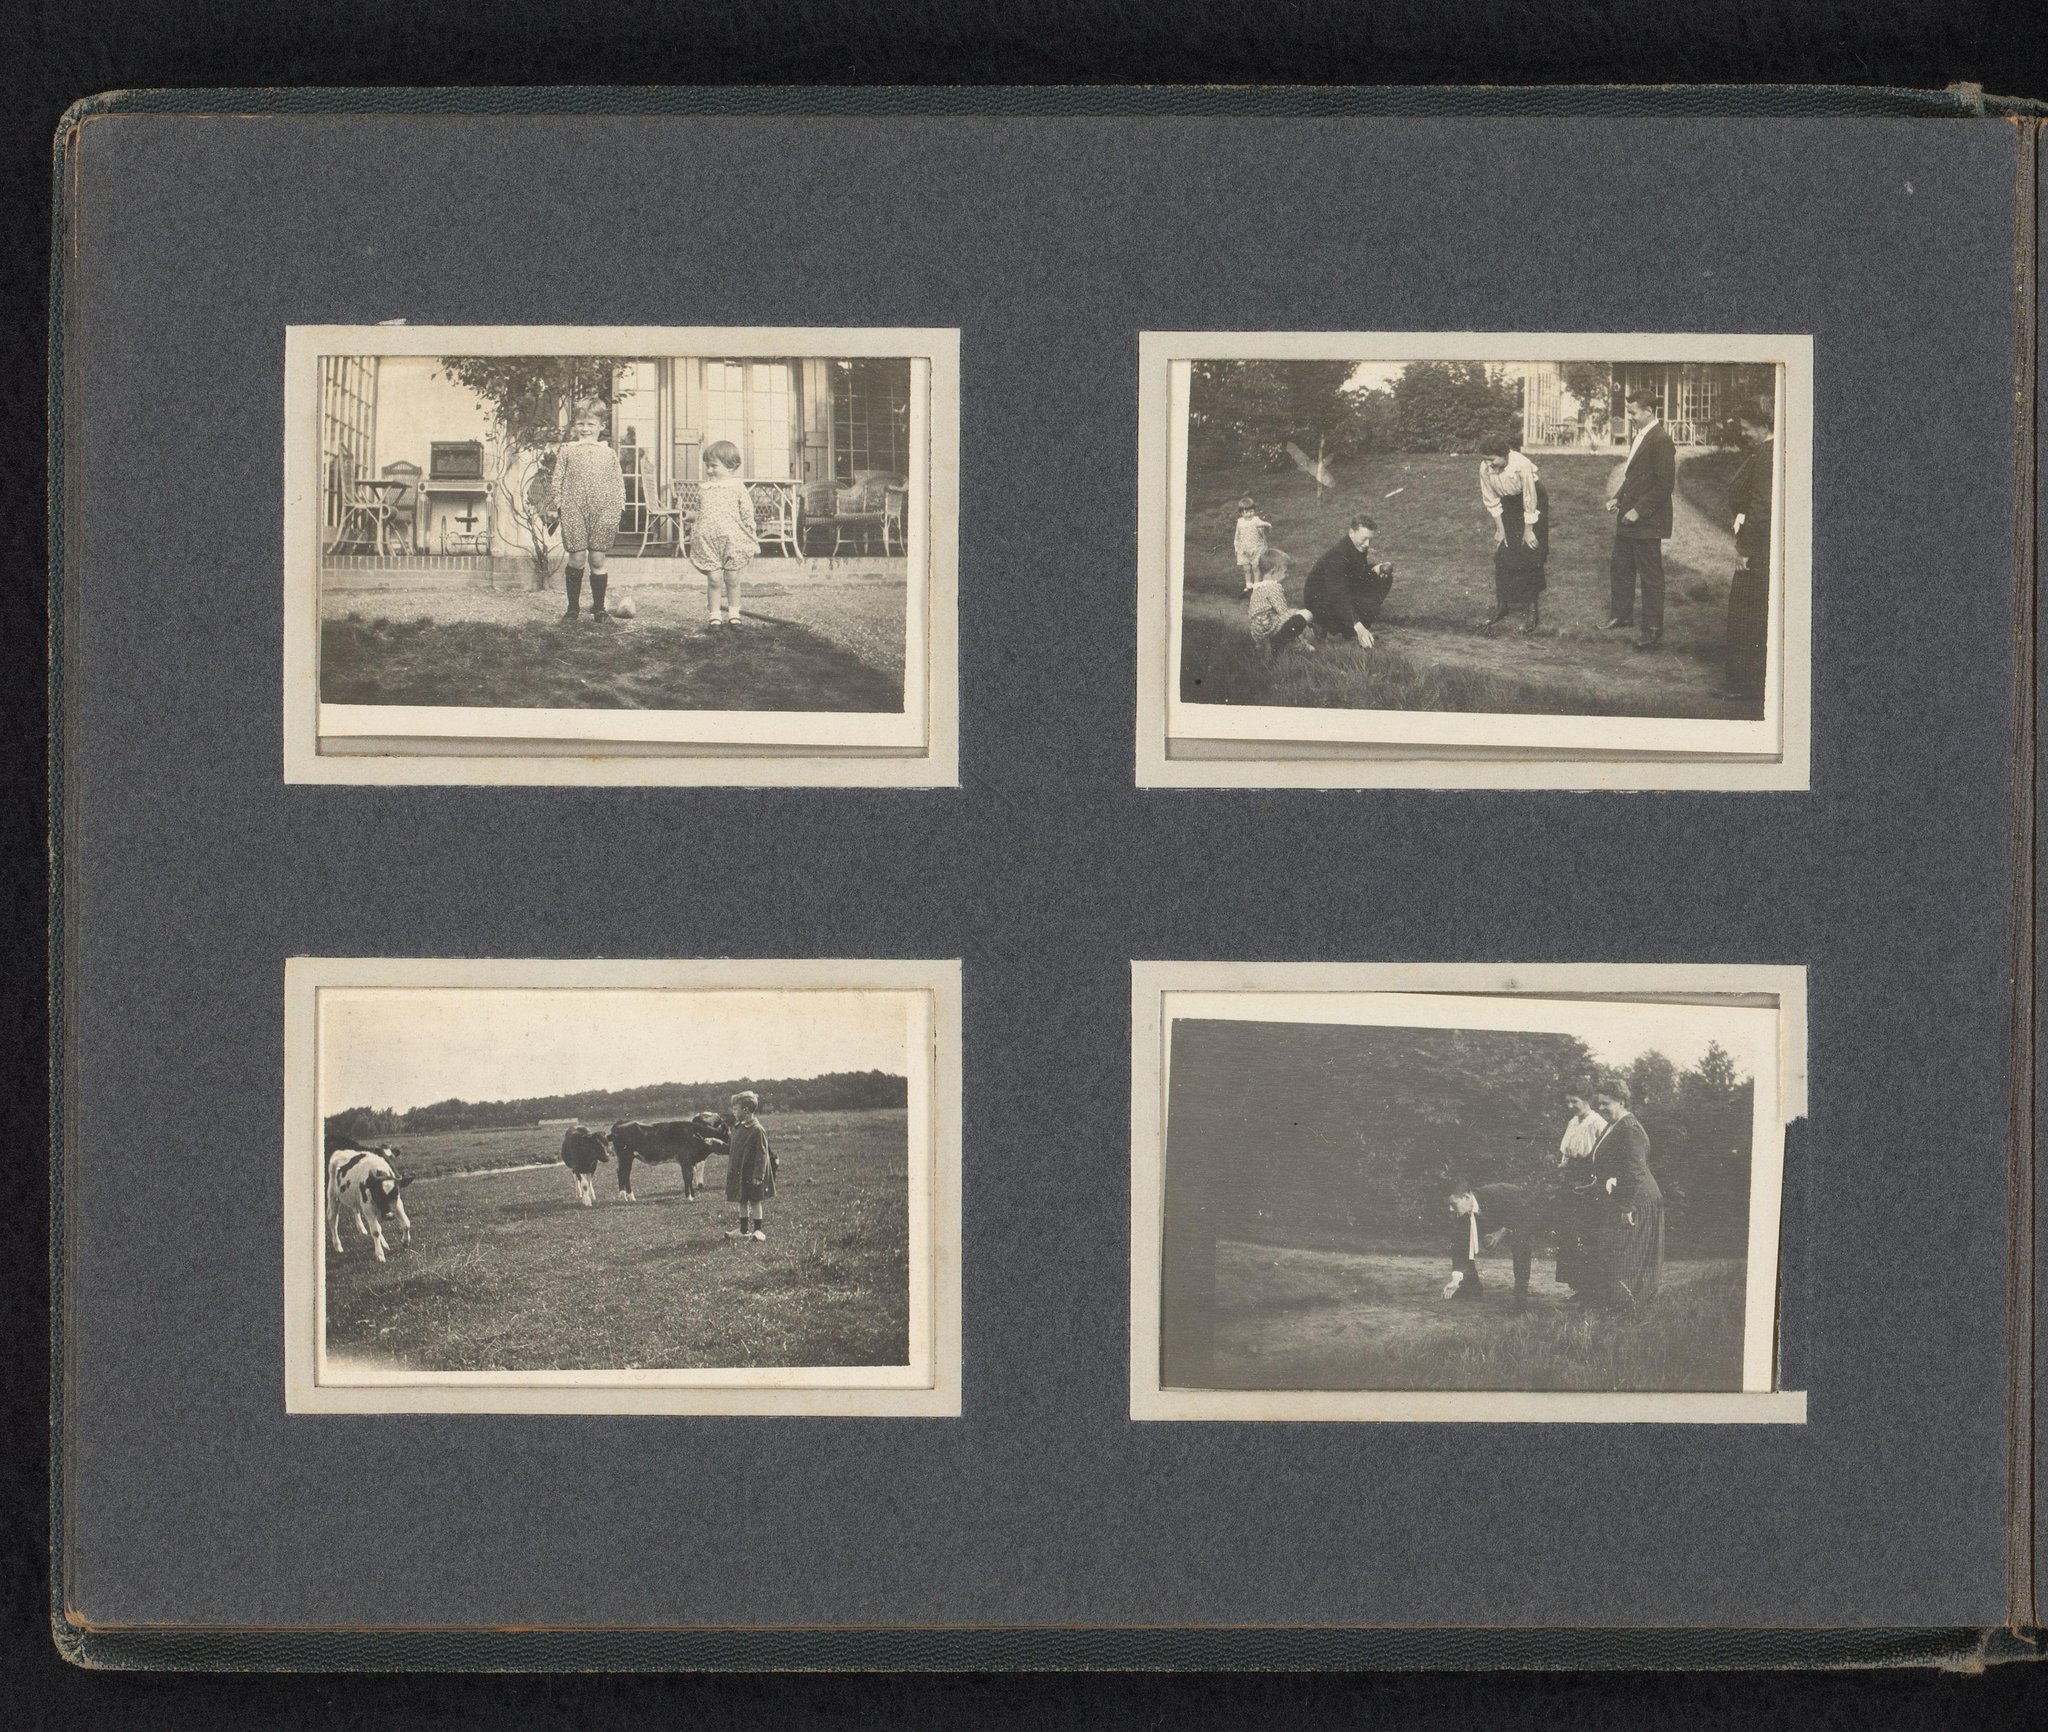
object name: photograph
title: Familie van den Berg in een tuin in Bergerac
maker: hendrik herman van den berg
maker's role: amateurfotograaf, jurist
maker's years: 1875-1944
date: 1907-1915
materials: paper, cardboard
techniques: gelatin silver print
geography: bergerac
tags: family life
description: Deze foto's zijn onderdeel van een album.